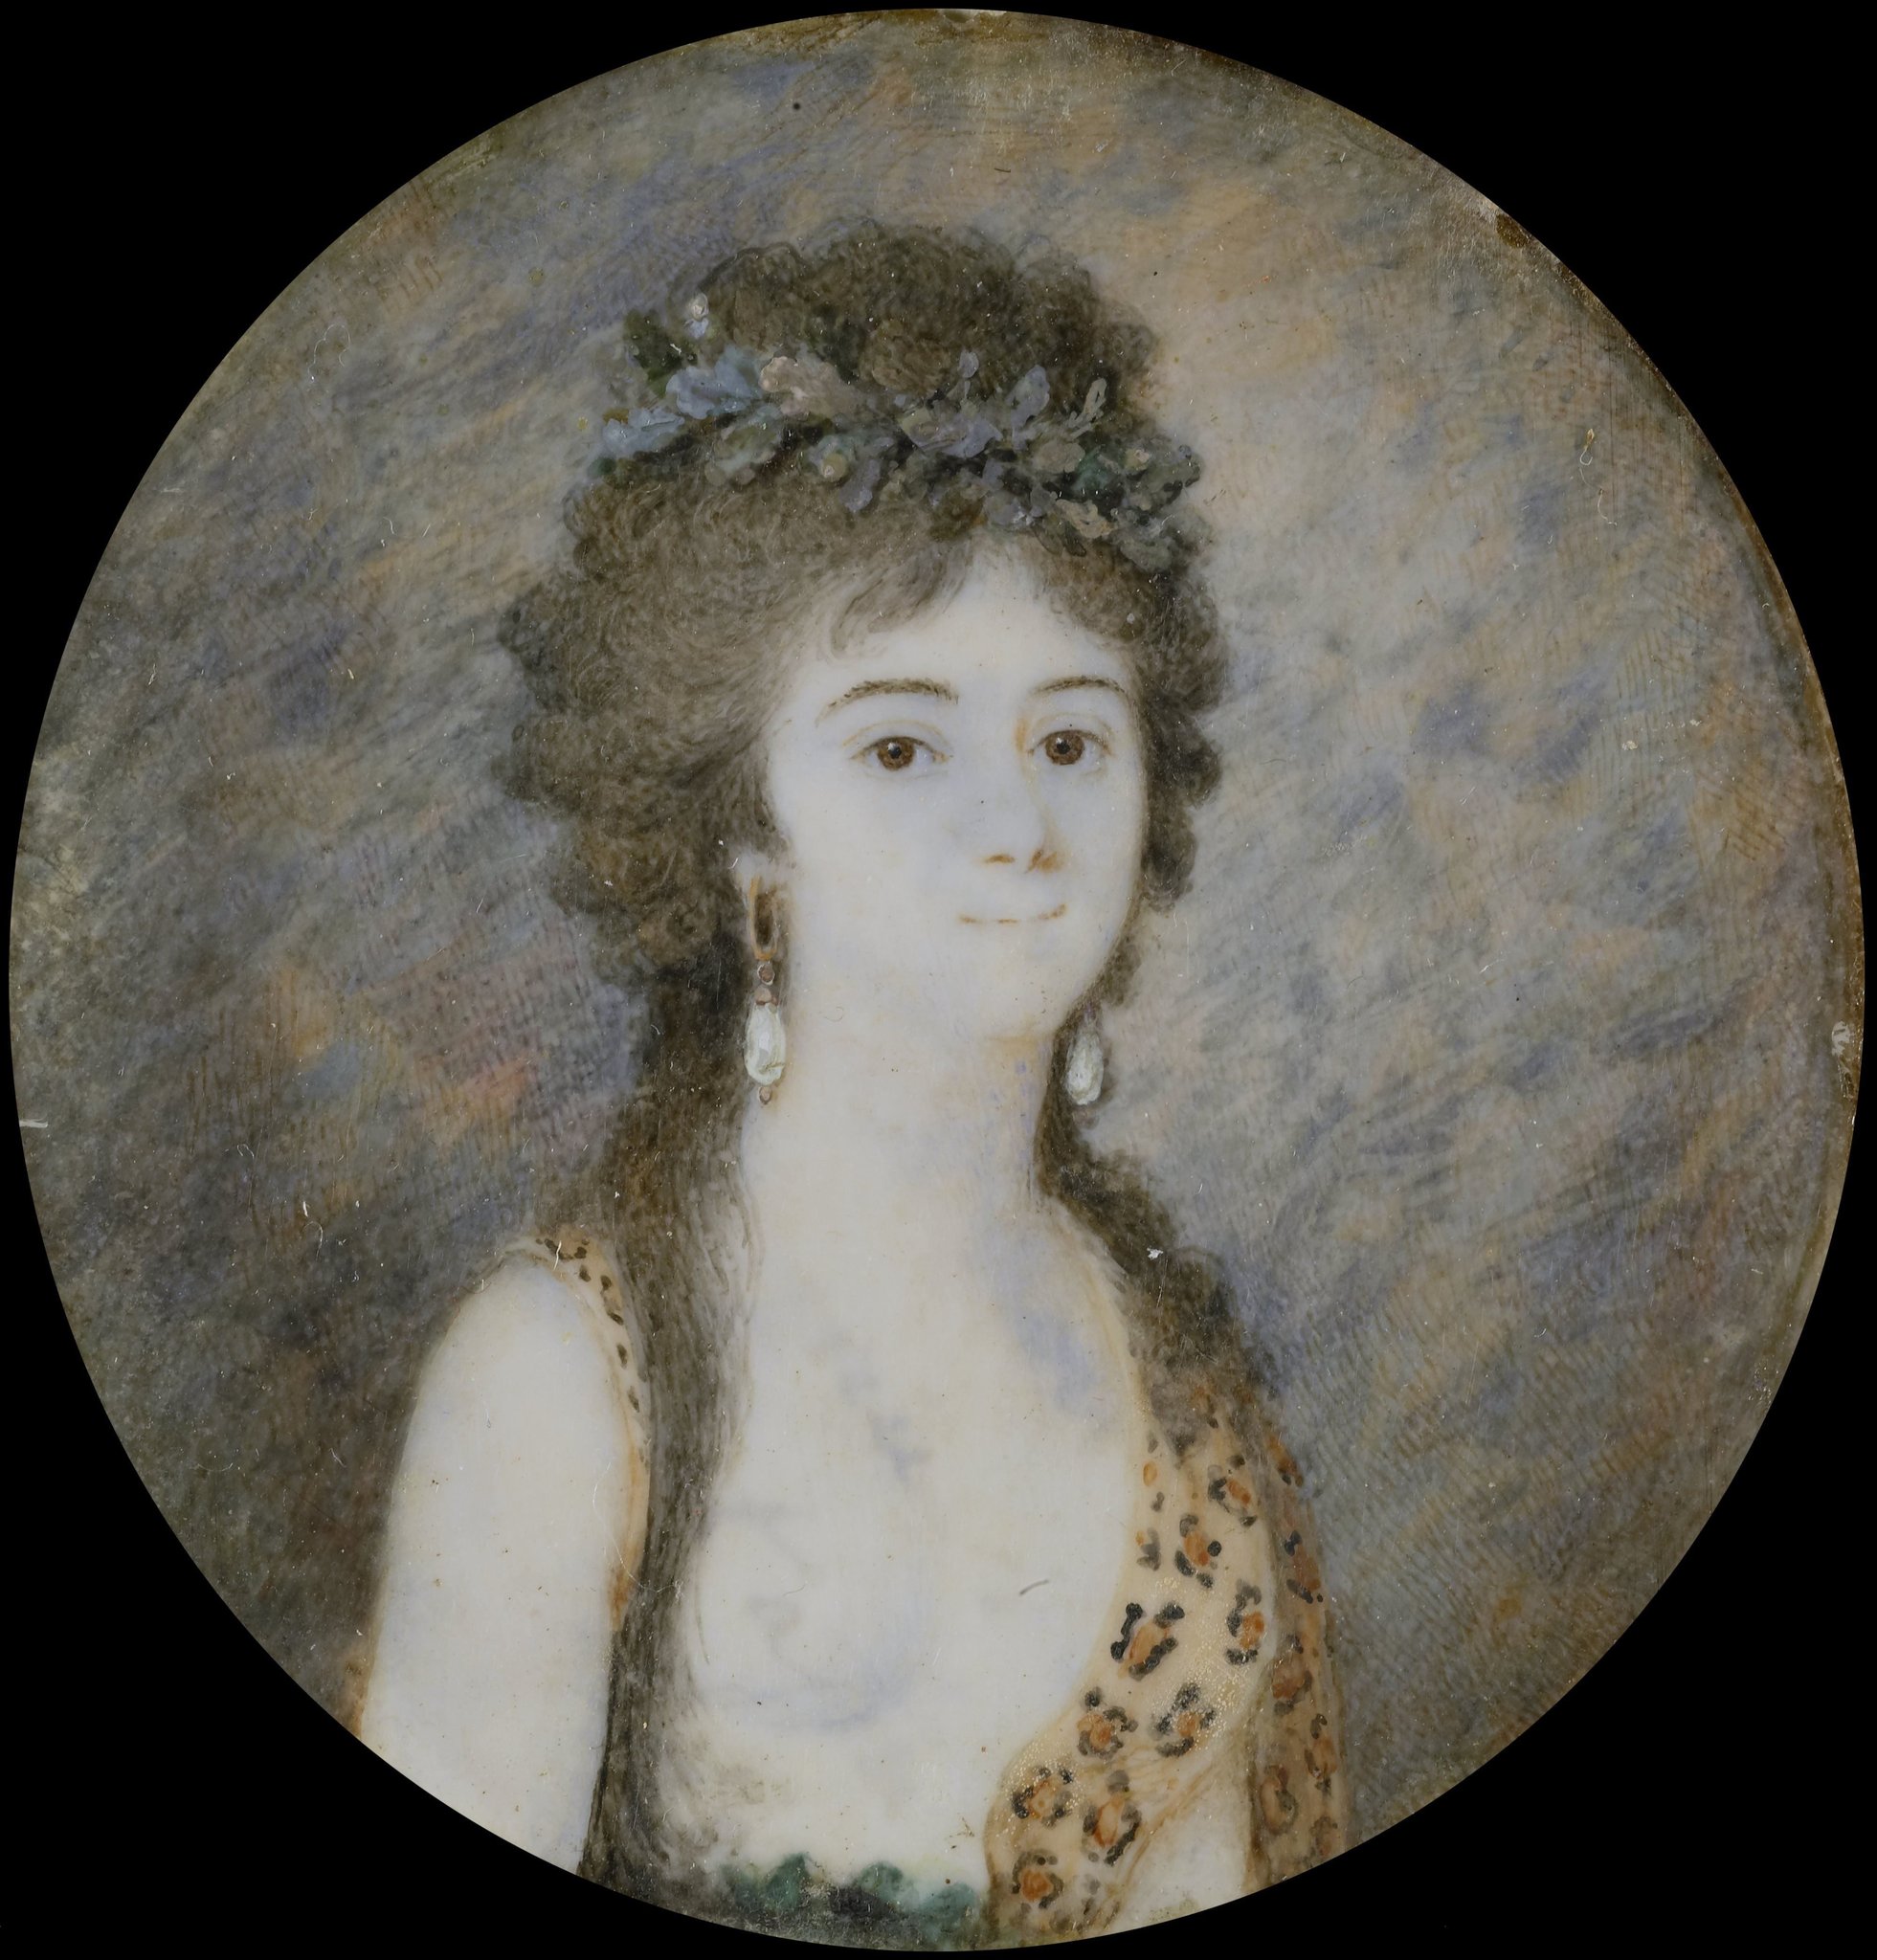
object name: painting, miniature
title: Portret van een jonge vrouw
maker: Anonymous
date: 1780-1799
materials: ivory, wood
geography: france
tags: historical persons not known by name - bb - woman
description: Portrait of a young woman. French school. Ivory, c. 1790.